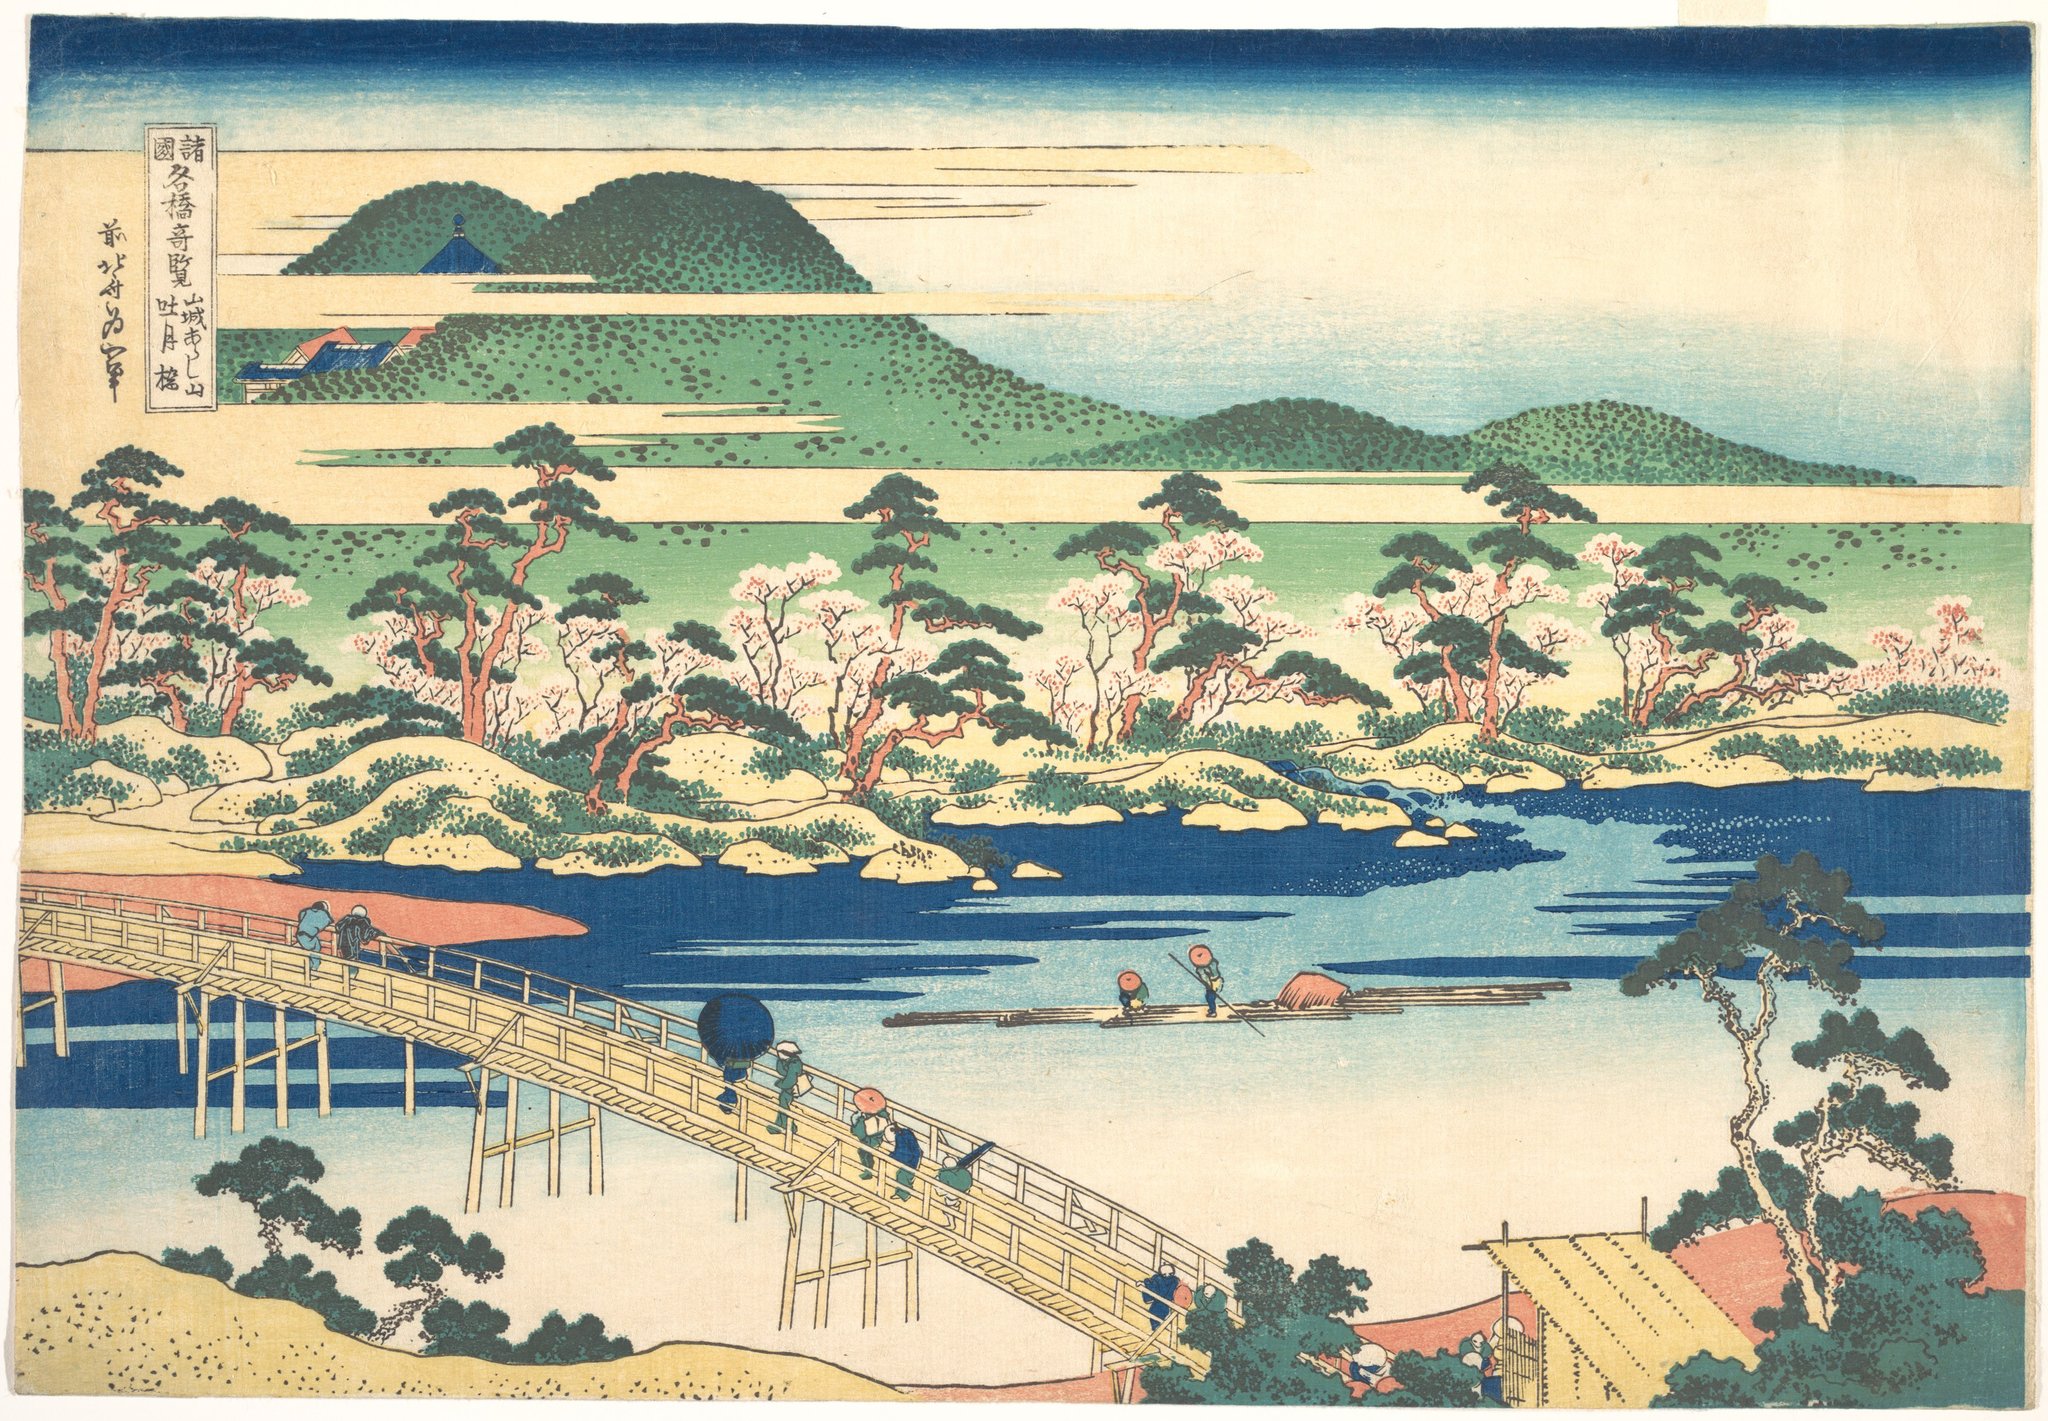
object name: woodblock print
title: Togetsu Bridge at Arashiyama in Yamashiro, from the series Remarkable Views of Bridges in Various Provinces (Shokoku meikyō kiran)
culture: japanese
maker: katsushika hokusai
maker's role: artist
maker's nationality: japanese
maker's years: 1760-1849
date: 1830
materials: ink, paper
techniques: woodblock print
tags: bridges,hills,landscapes